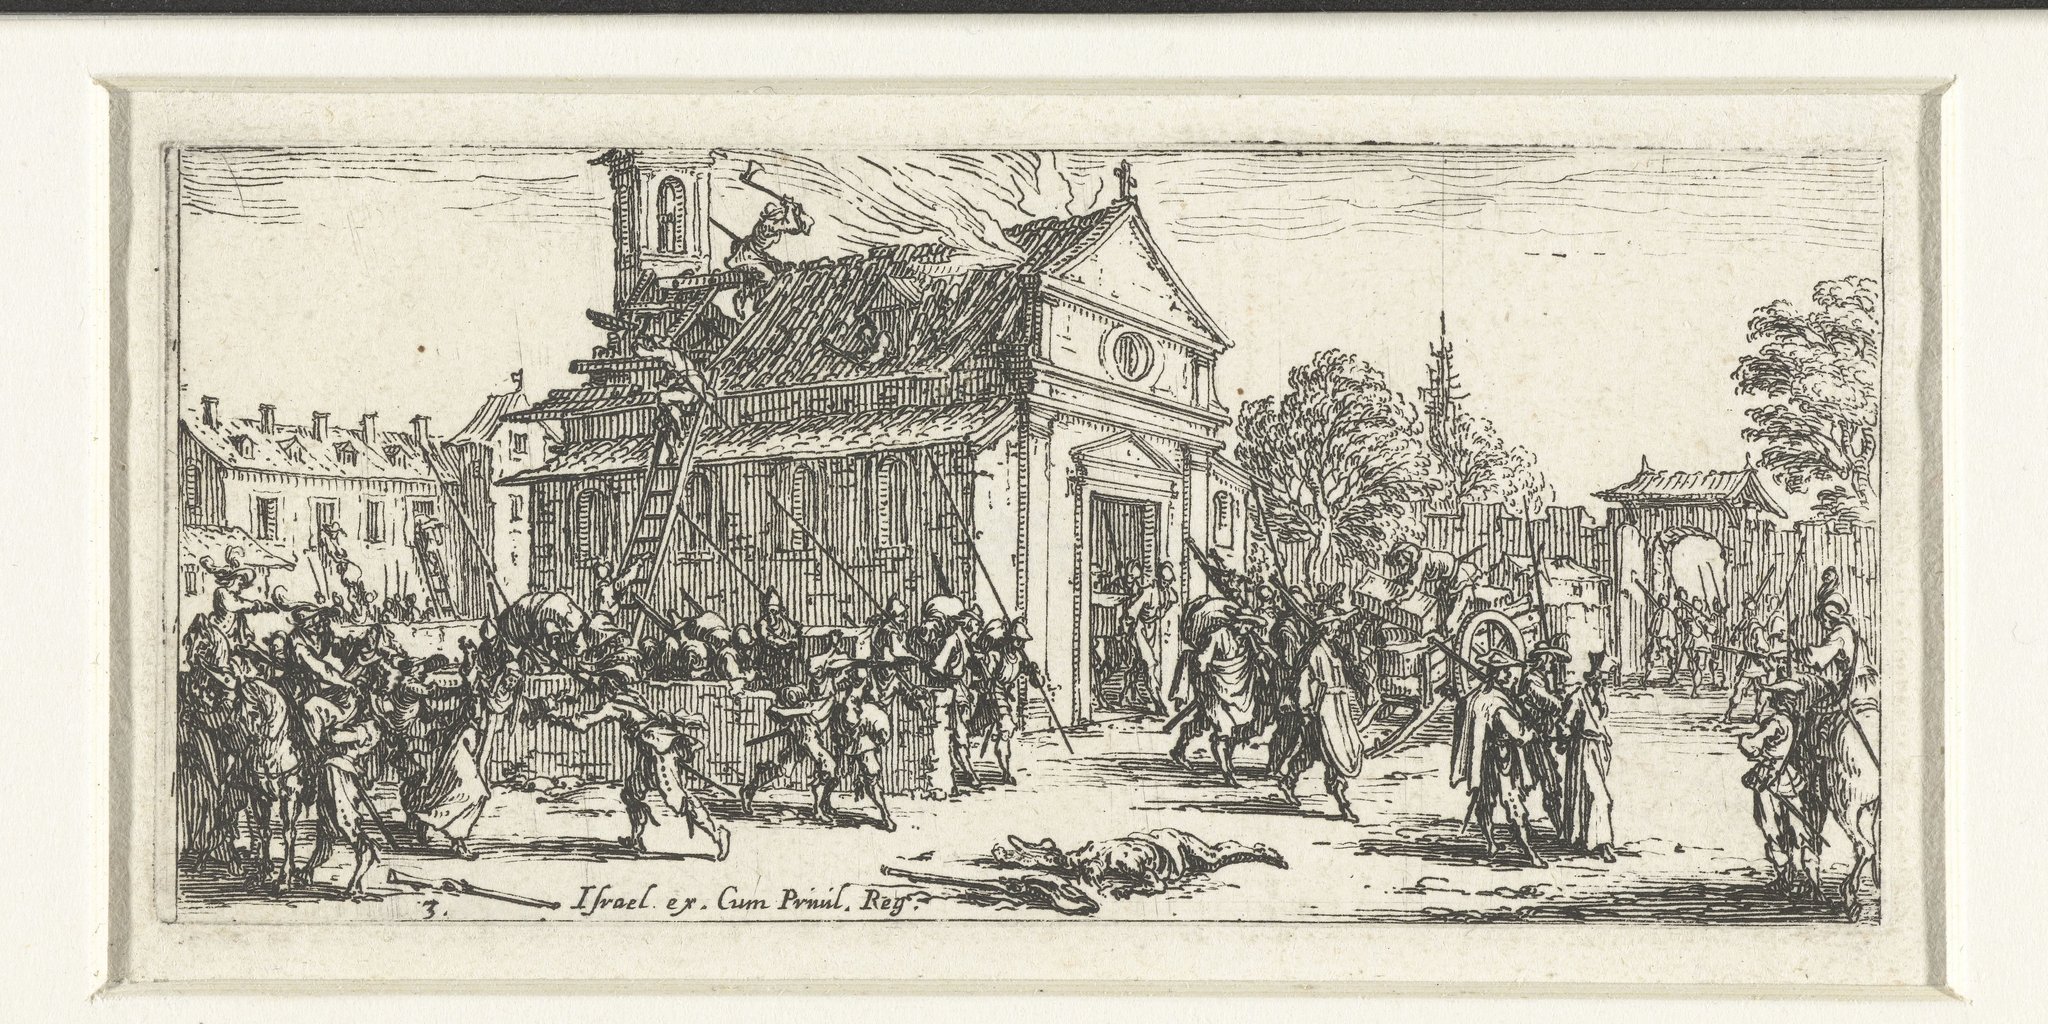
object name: print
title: De gruwelen van de oorlog (klein)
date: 1632-1636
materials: paper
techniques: etching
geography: paris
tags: abbey, monastery, convent ~ roman catholic church, plundering ~ soldiers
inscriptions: collector's mark: Lugt 240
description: Op een kloosterterrein roven soldaten spullen uit gebouwen en laden ze op een kar. Nonnen en monniken worden gevangen genomen. De kloosterkerk staat in brand. Deze prent is onderdeel van een serie van zes (zeven incl. titelprent) kleine prenten met voorstellingen van diverse soorten ellende die oorlogvoering met zich meebrengt.